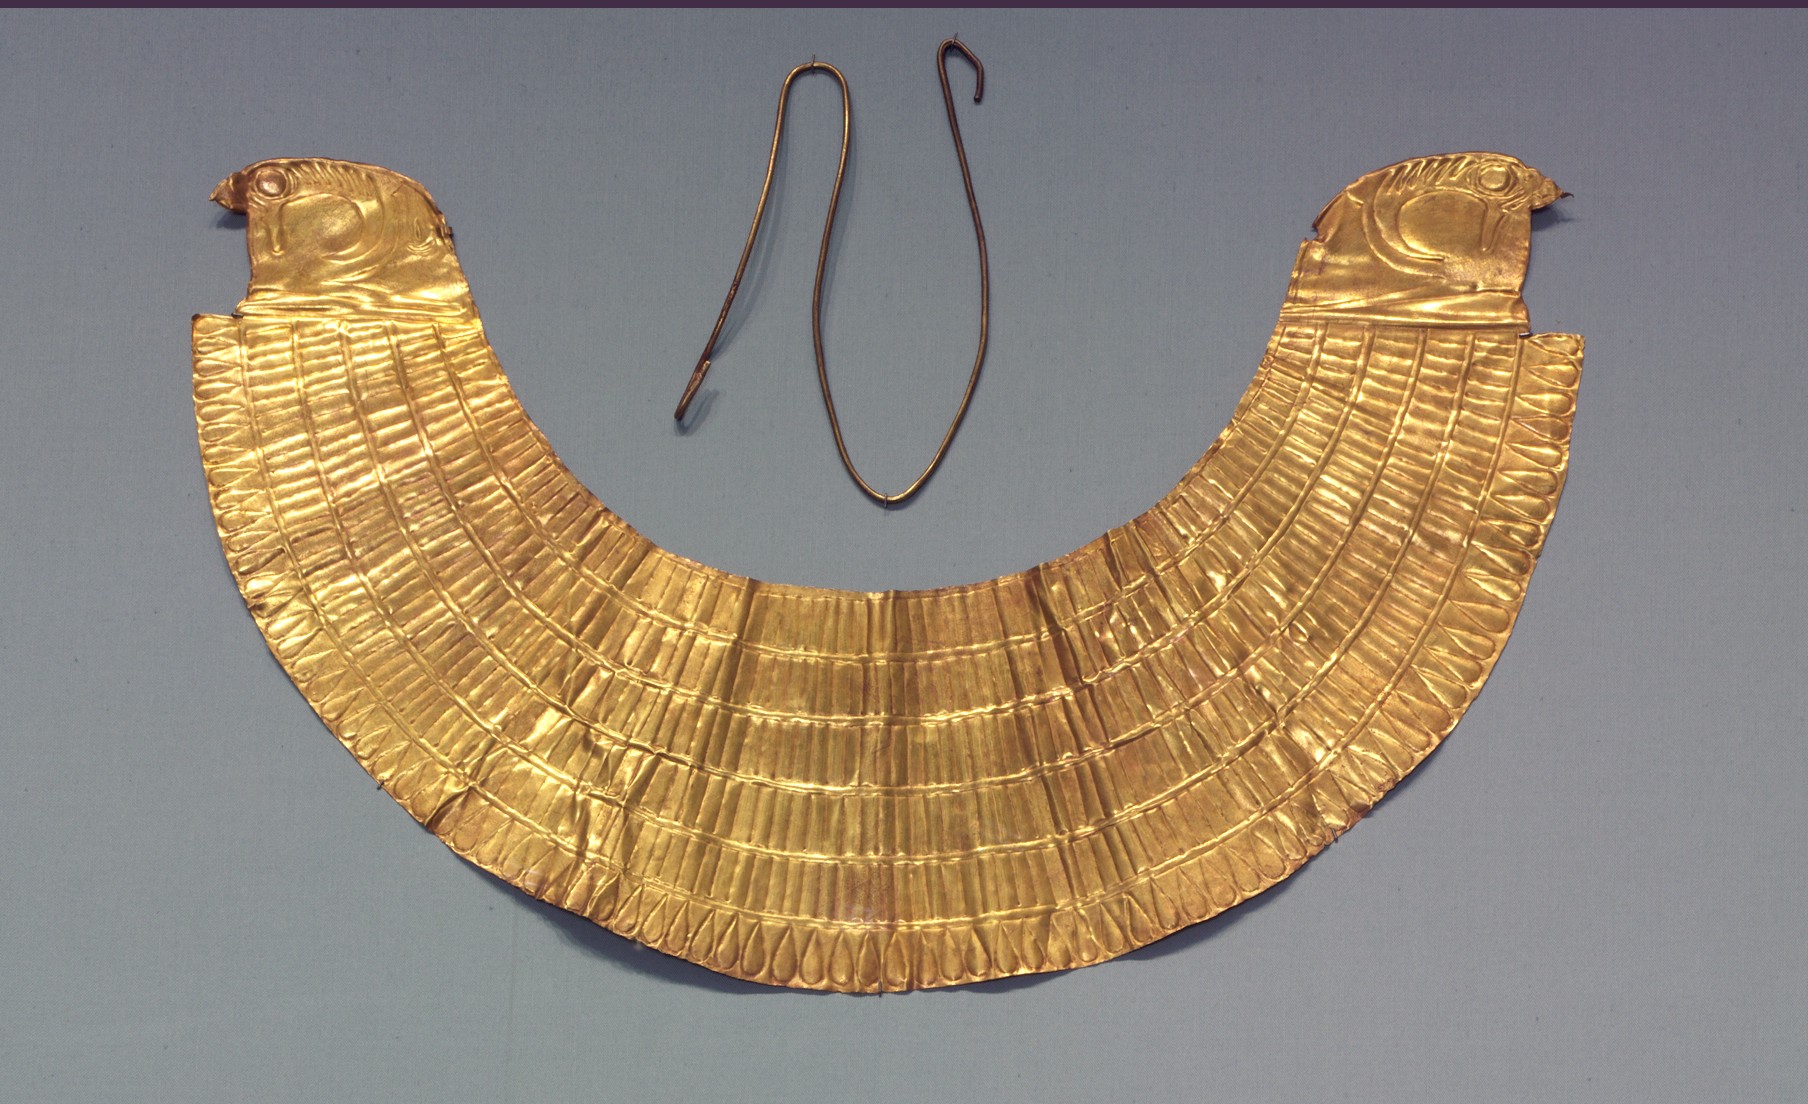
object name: funerary broad collar with falcon head terminal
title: Broad Collar with Falcon-Head Terminals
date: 1479-1425 BCE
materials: gold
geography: egypt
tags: falcons